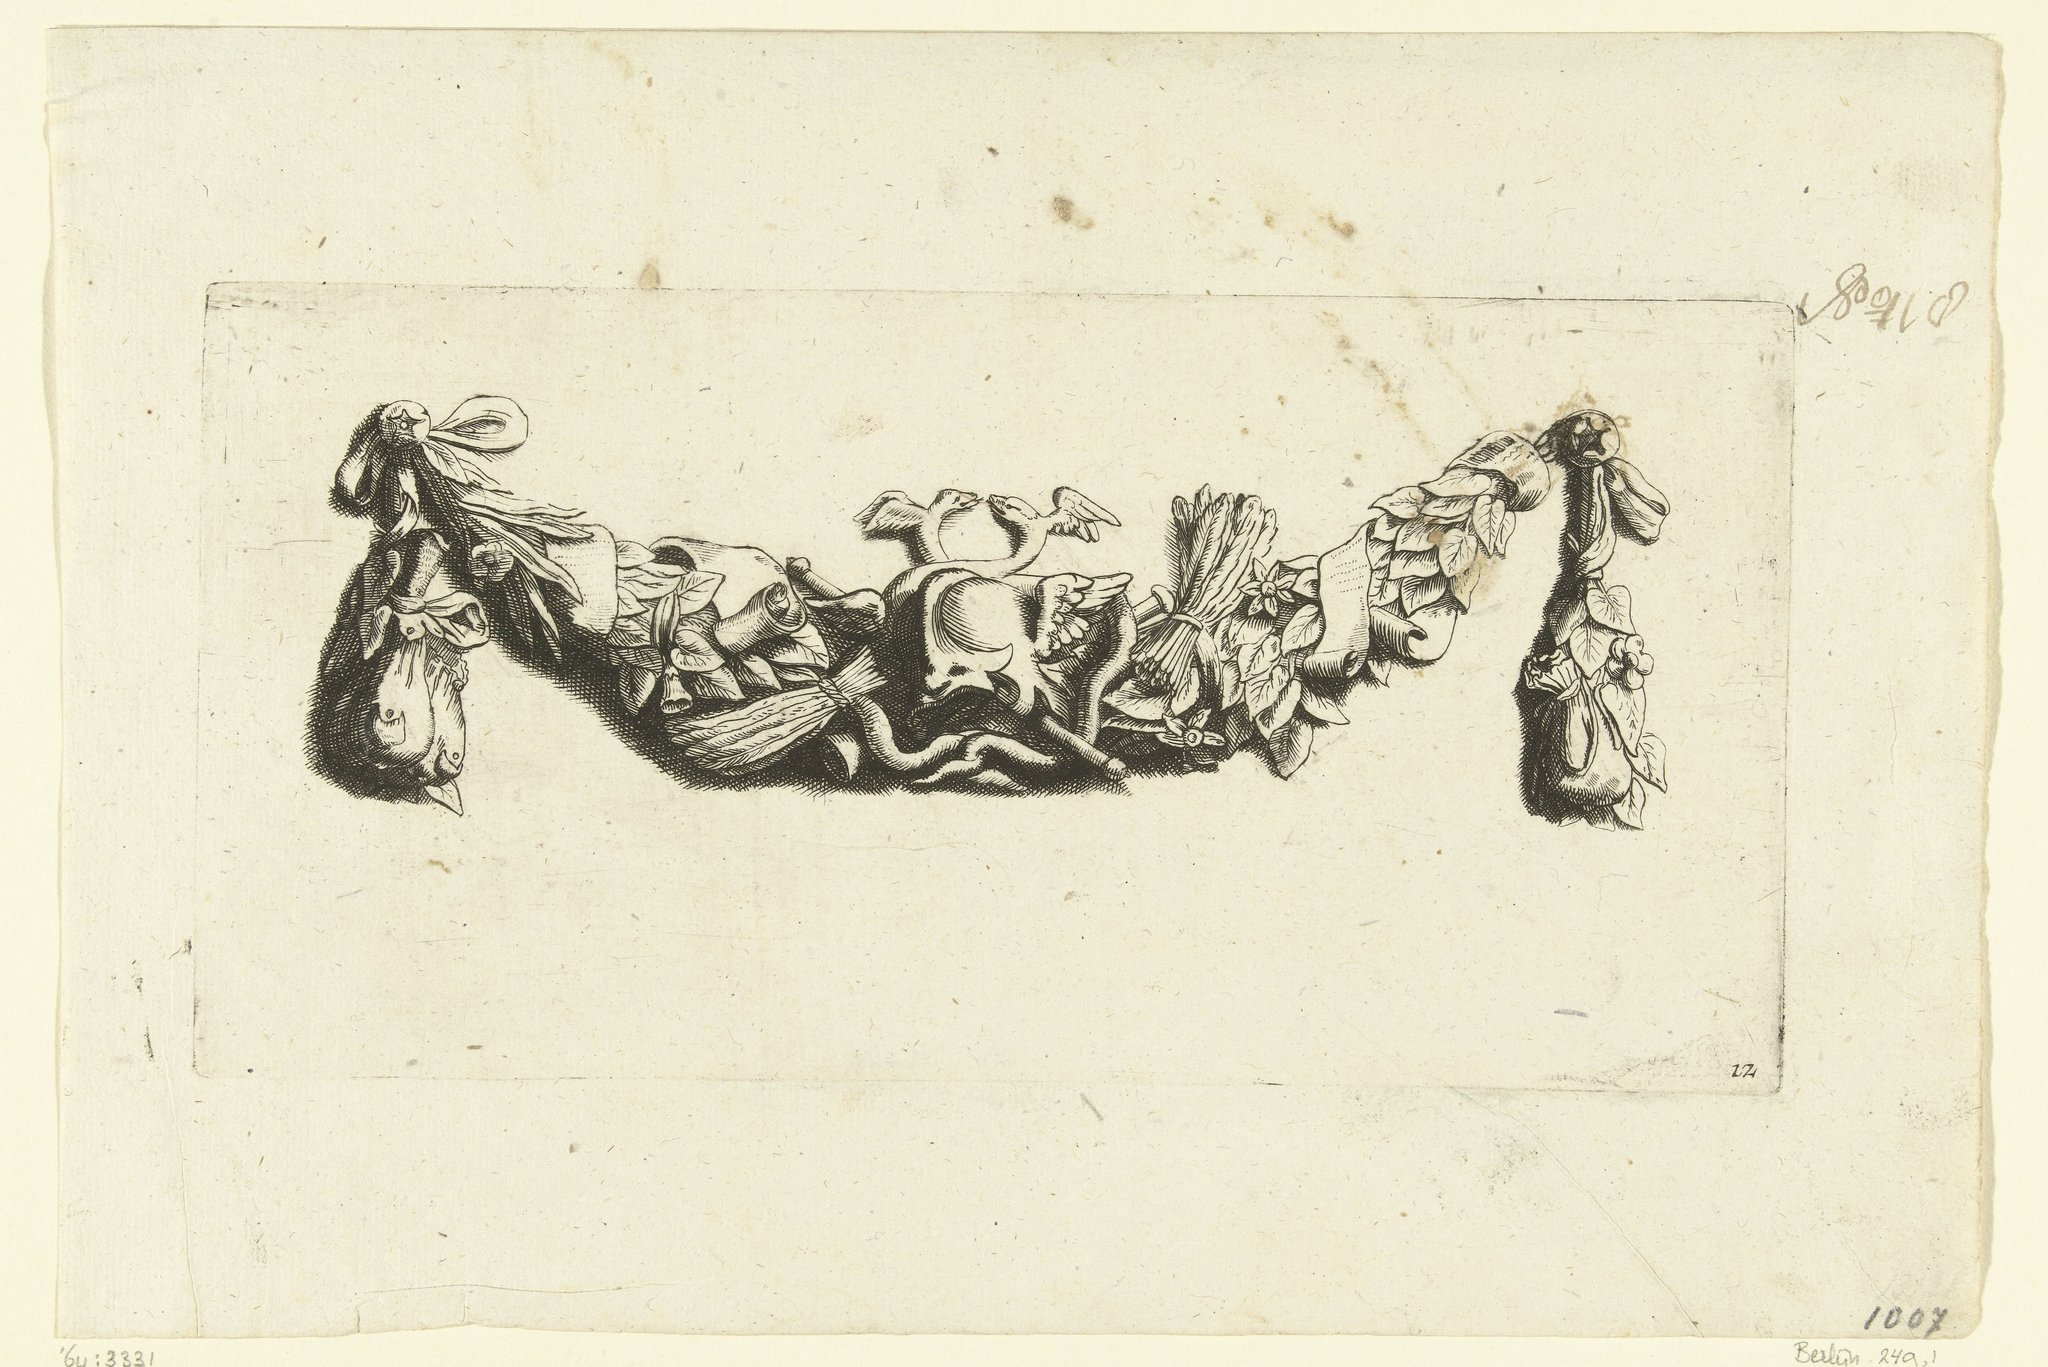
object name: ornament print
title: Festoen van bladeren en attributen van Mercurius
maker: Anonymous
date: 1665-1700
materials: paper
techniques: etching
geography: amsterdam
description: Kopie naar festoen uit de serie Prima Pars Praecipuarum.../ Het Eerste Deel Van de voornaemste Statuen ende Cieraten.../ La Premier Partie....